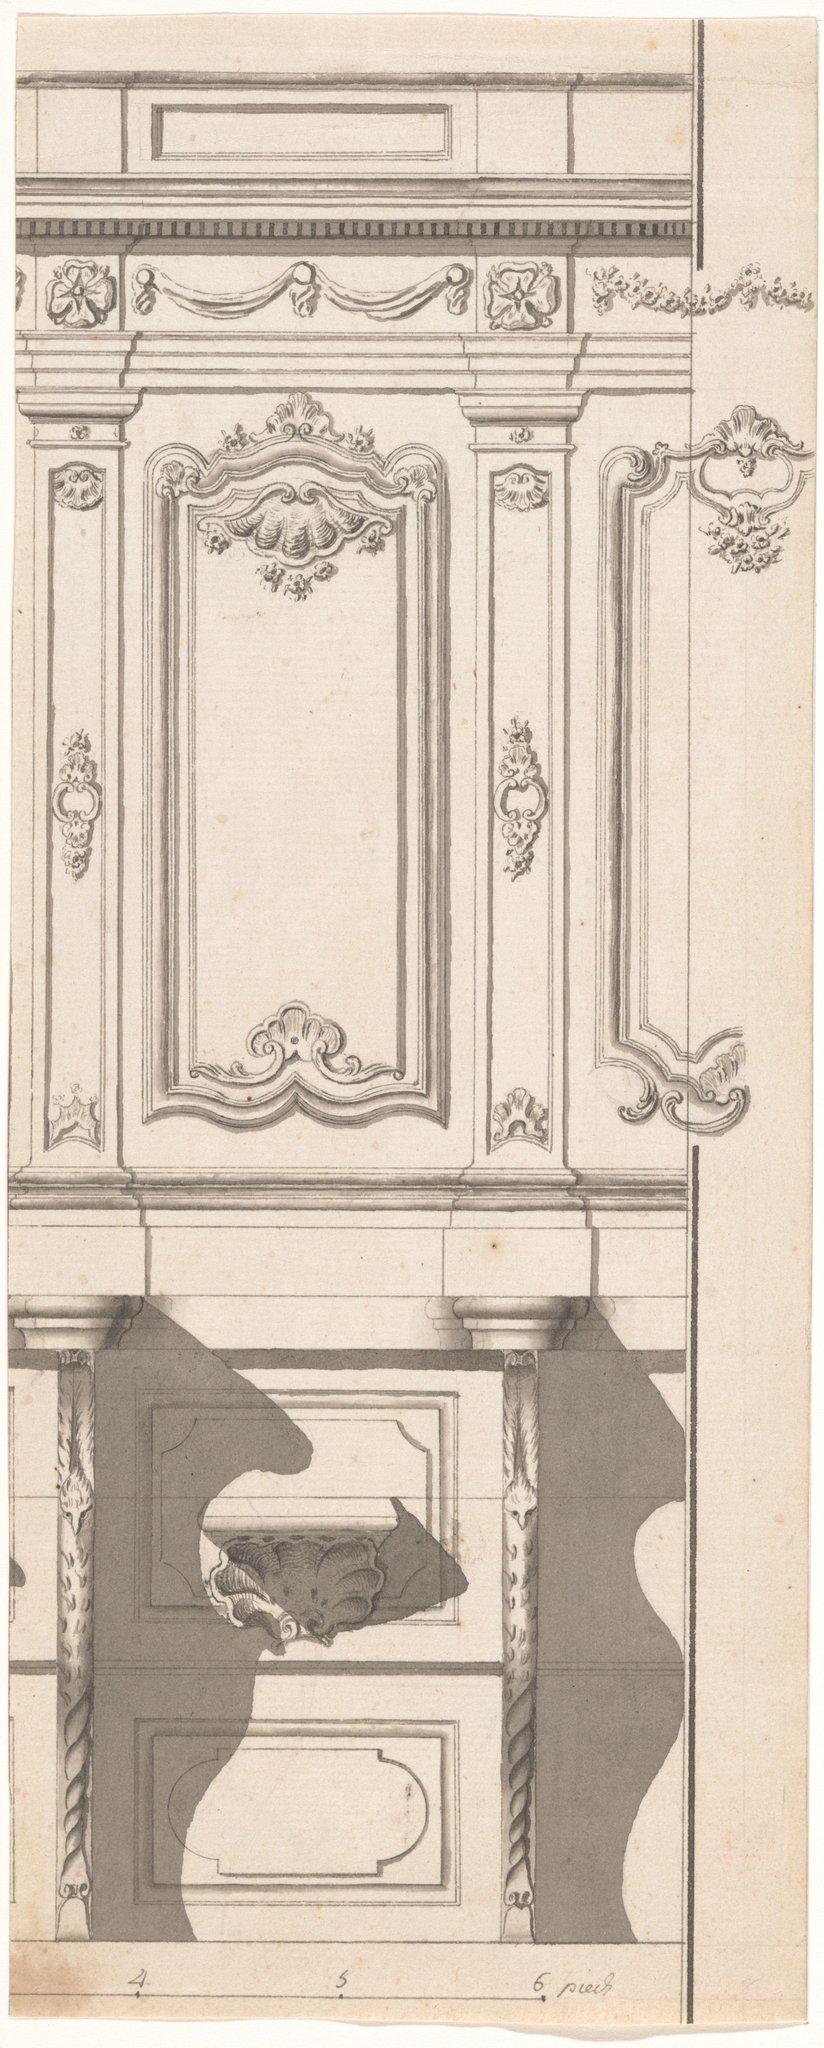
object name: drawing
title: Ontwerp voor een koorgestoelte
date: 1770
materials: graphite, paper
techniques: brush, pen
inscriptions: watermark